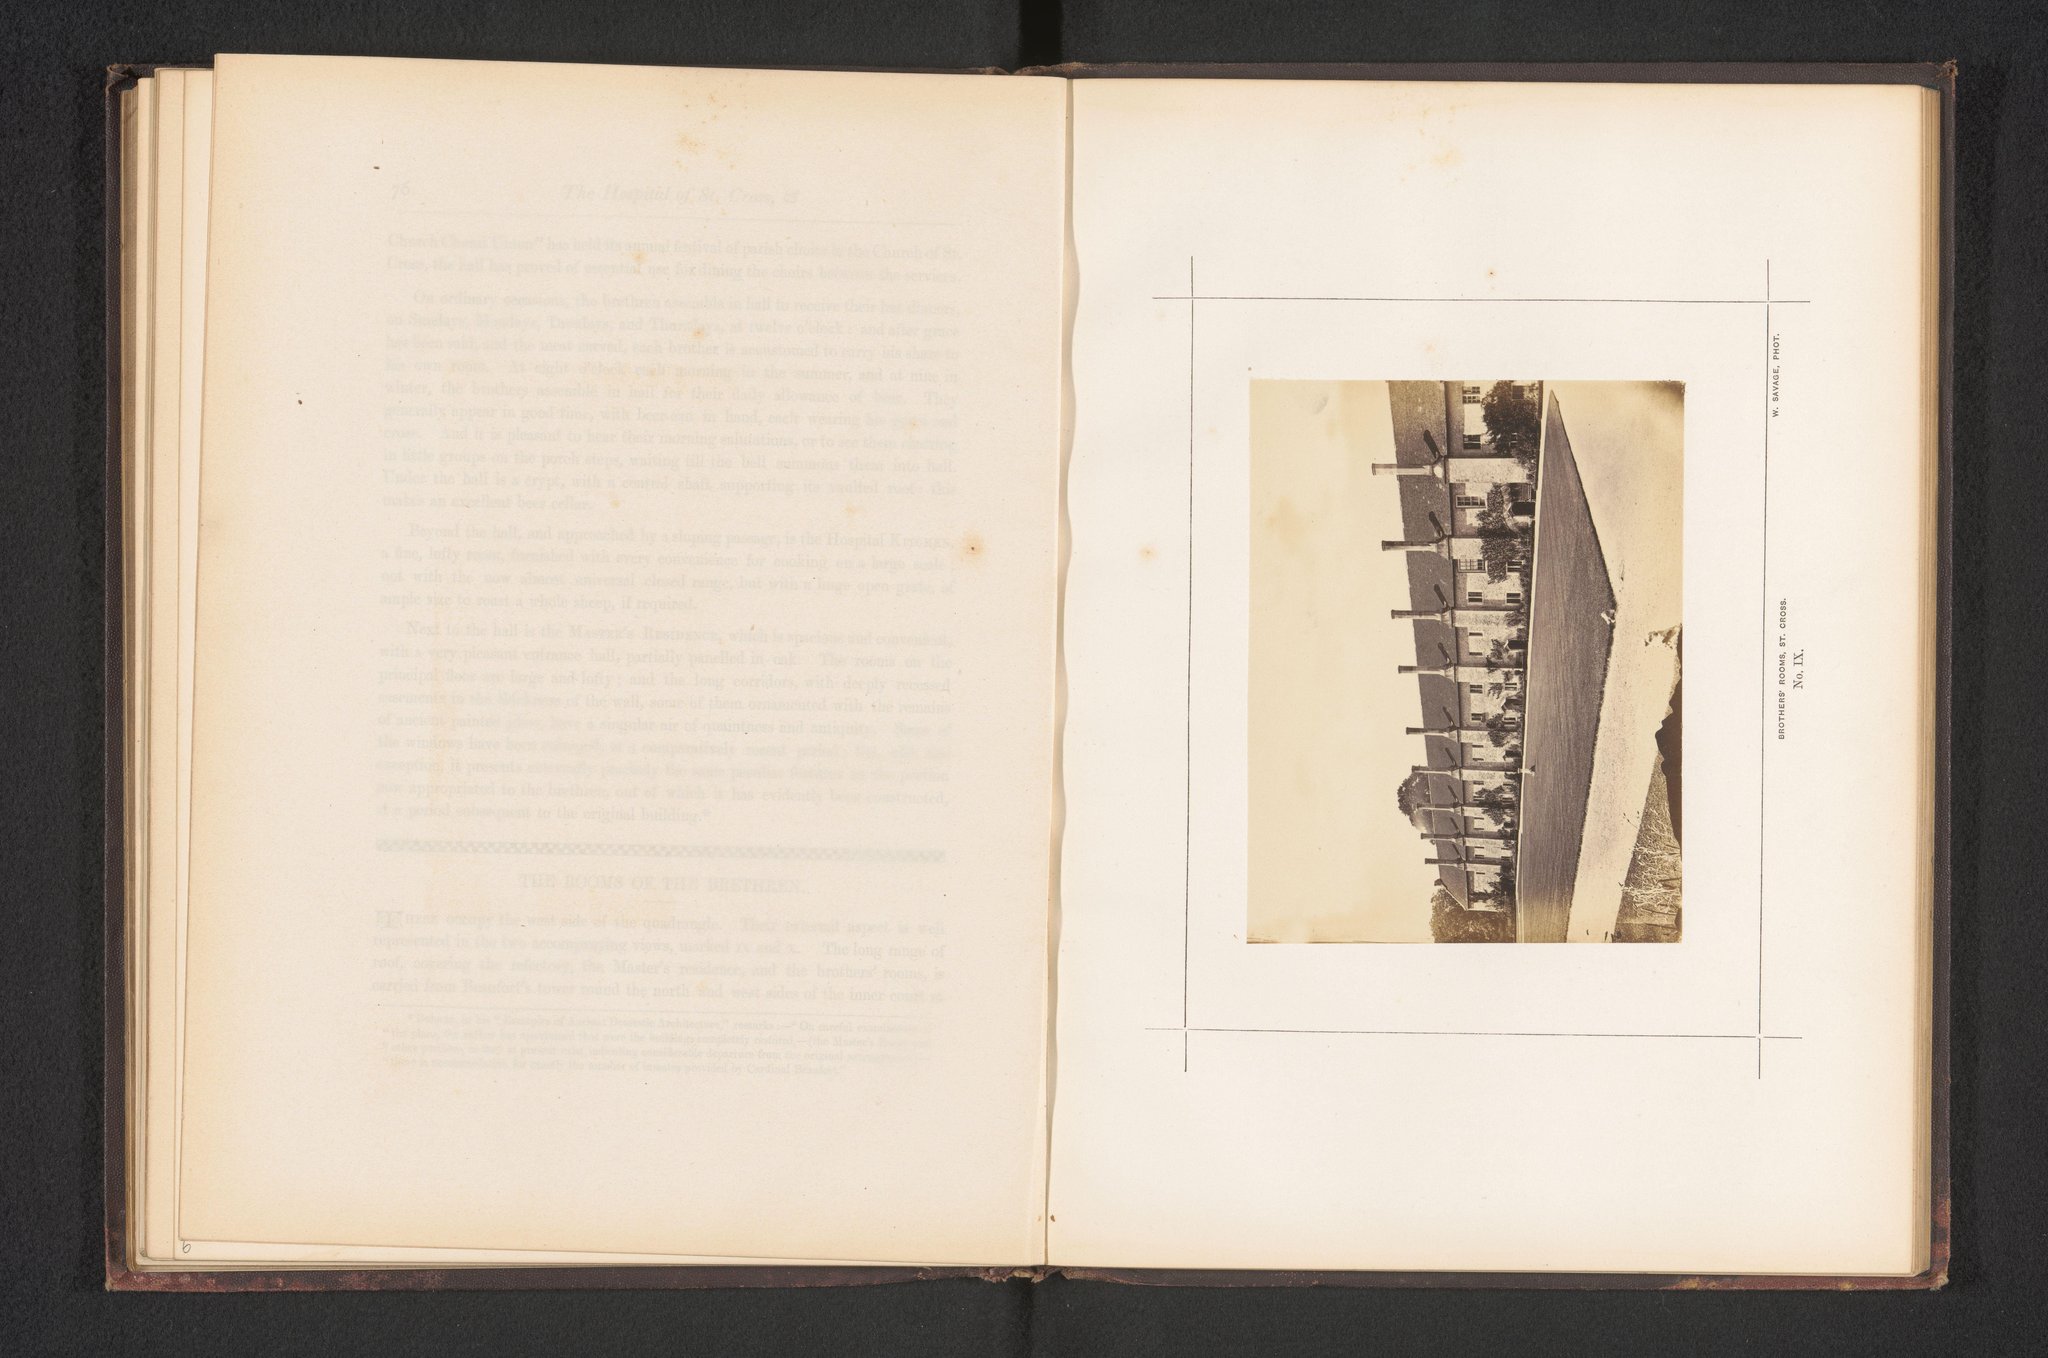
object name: page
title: Gezicht op het slaapvertrek van St. Cross Church te Winchester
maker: william savage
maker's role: fotograaf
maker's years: 1817-1887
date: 1863-1868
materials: photographic support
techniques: albumen print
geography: winchester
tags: dormitory ~ monastery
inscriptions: inscription: ‘No. IX.’